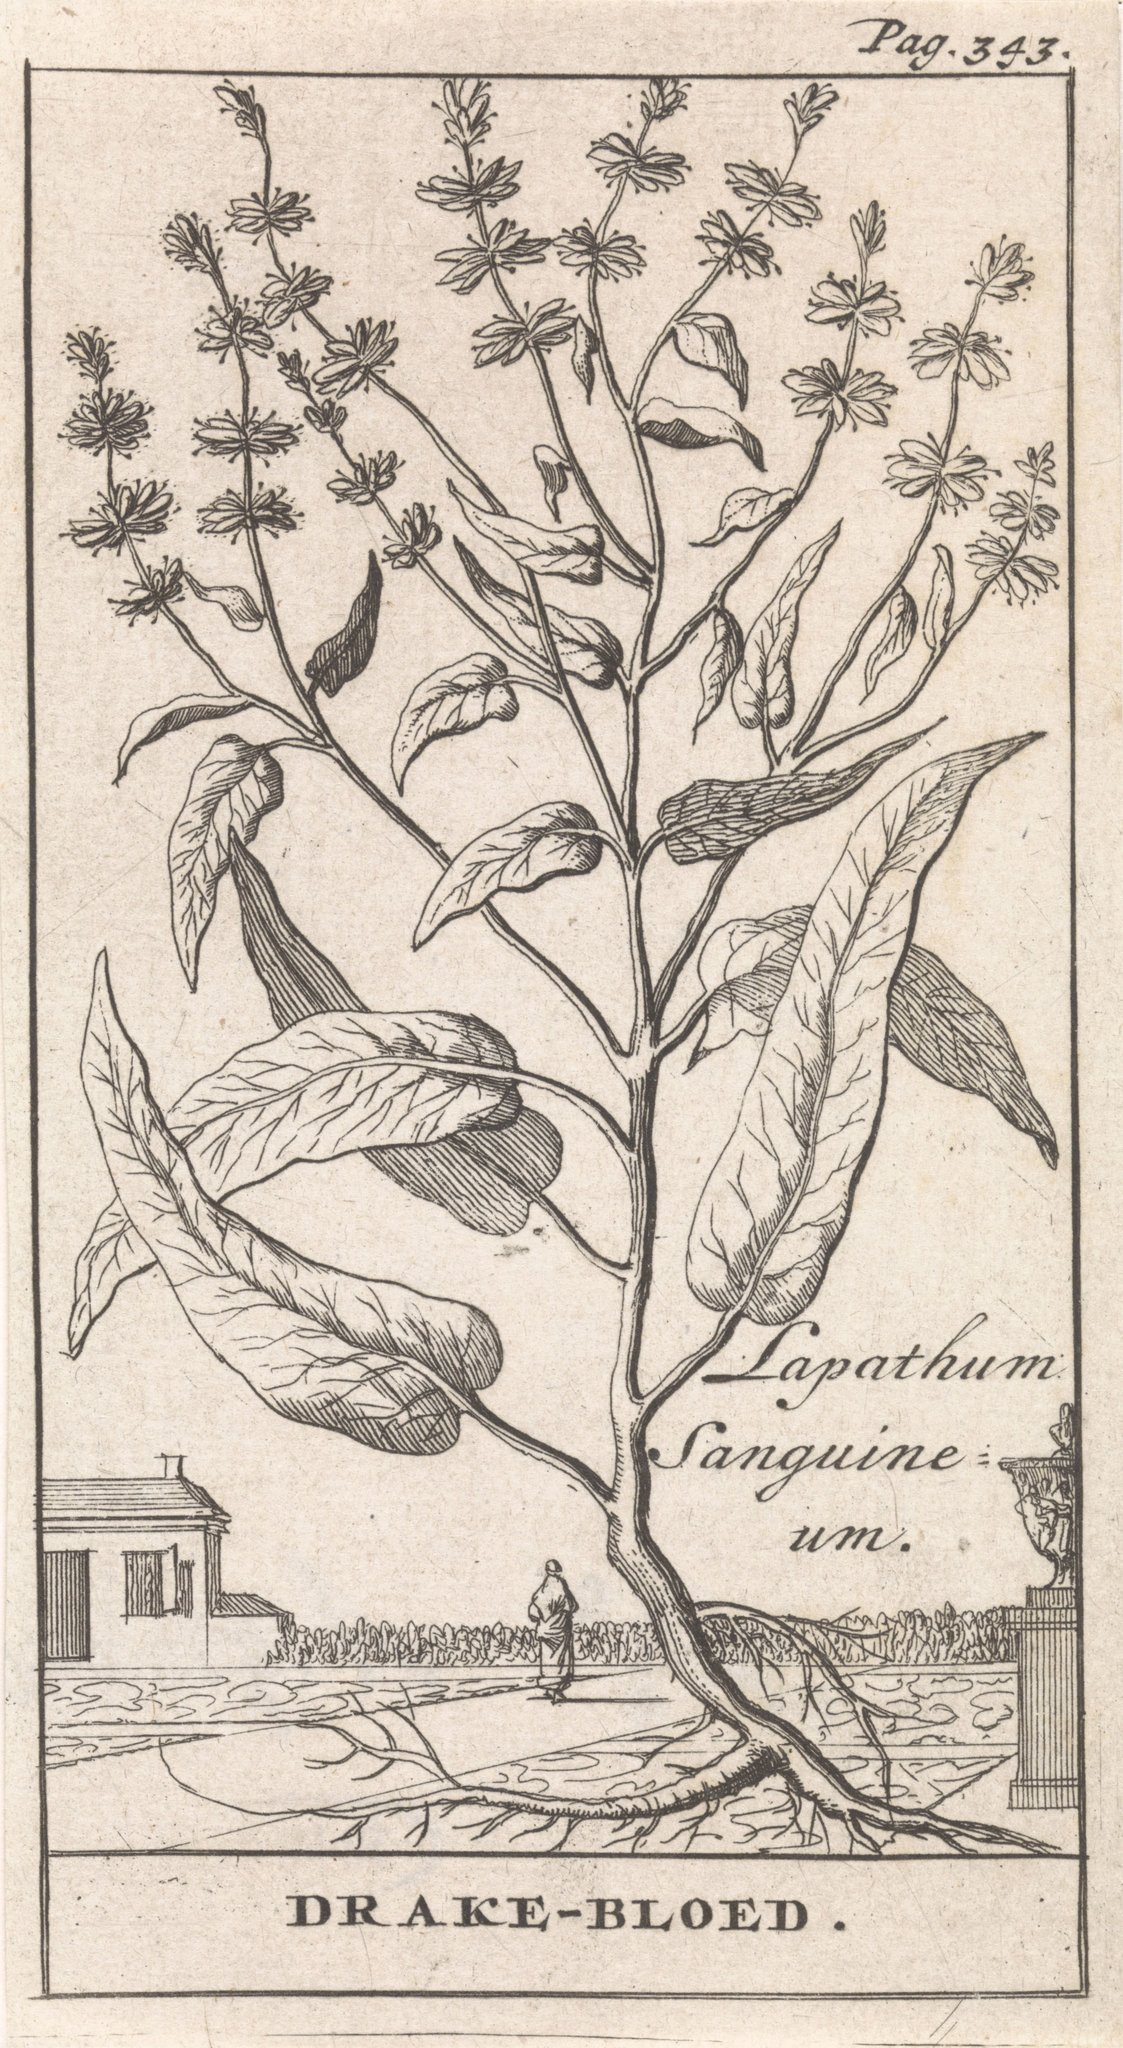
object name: print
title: Lapathum Sanguineum / Drake-bloed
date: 1698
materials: paper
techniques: etching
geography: amsterdam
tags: plants and herbs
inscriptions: collector's mark: Lugt 2228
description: Illustratie uit: Blankaart, Steven. Den Neder-landschen herbarius ofte Kruid-boek der voornaamste kruiden. Amsterdam: Jan Claesz ten Hoorn, 1698.